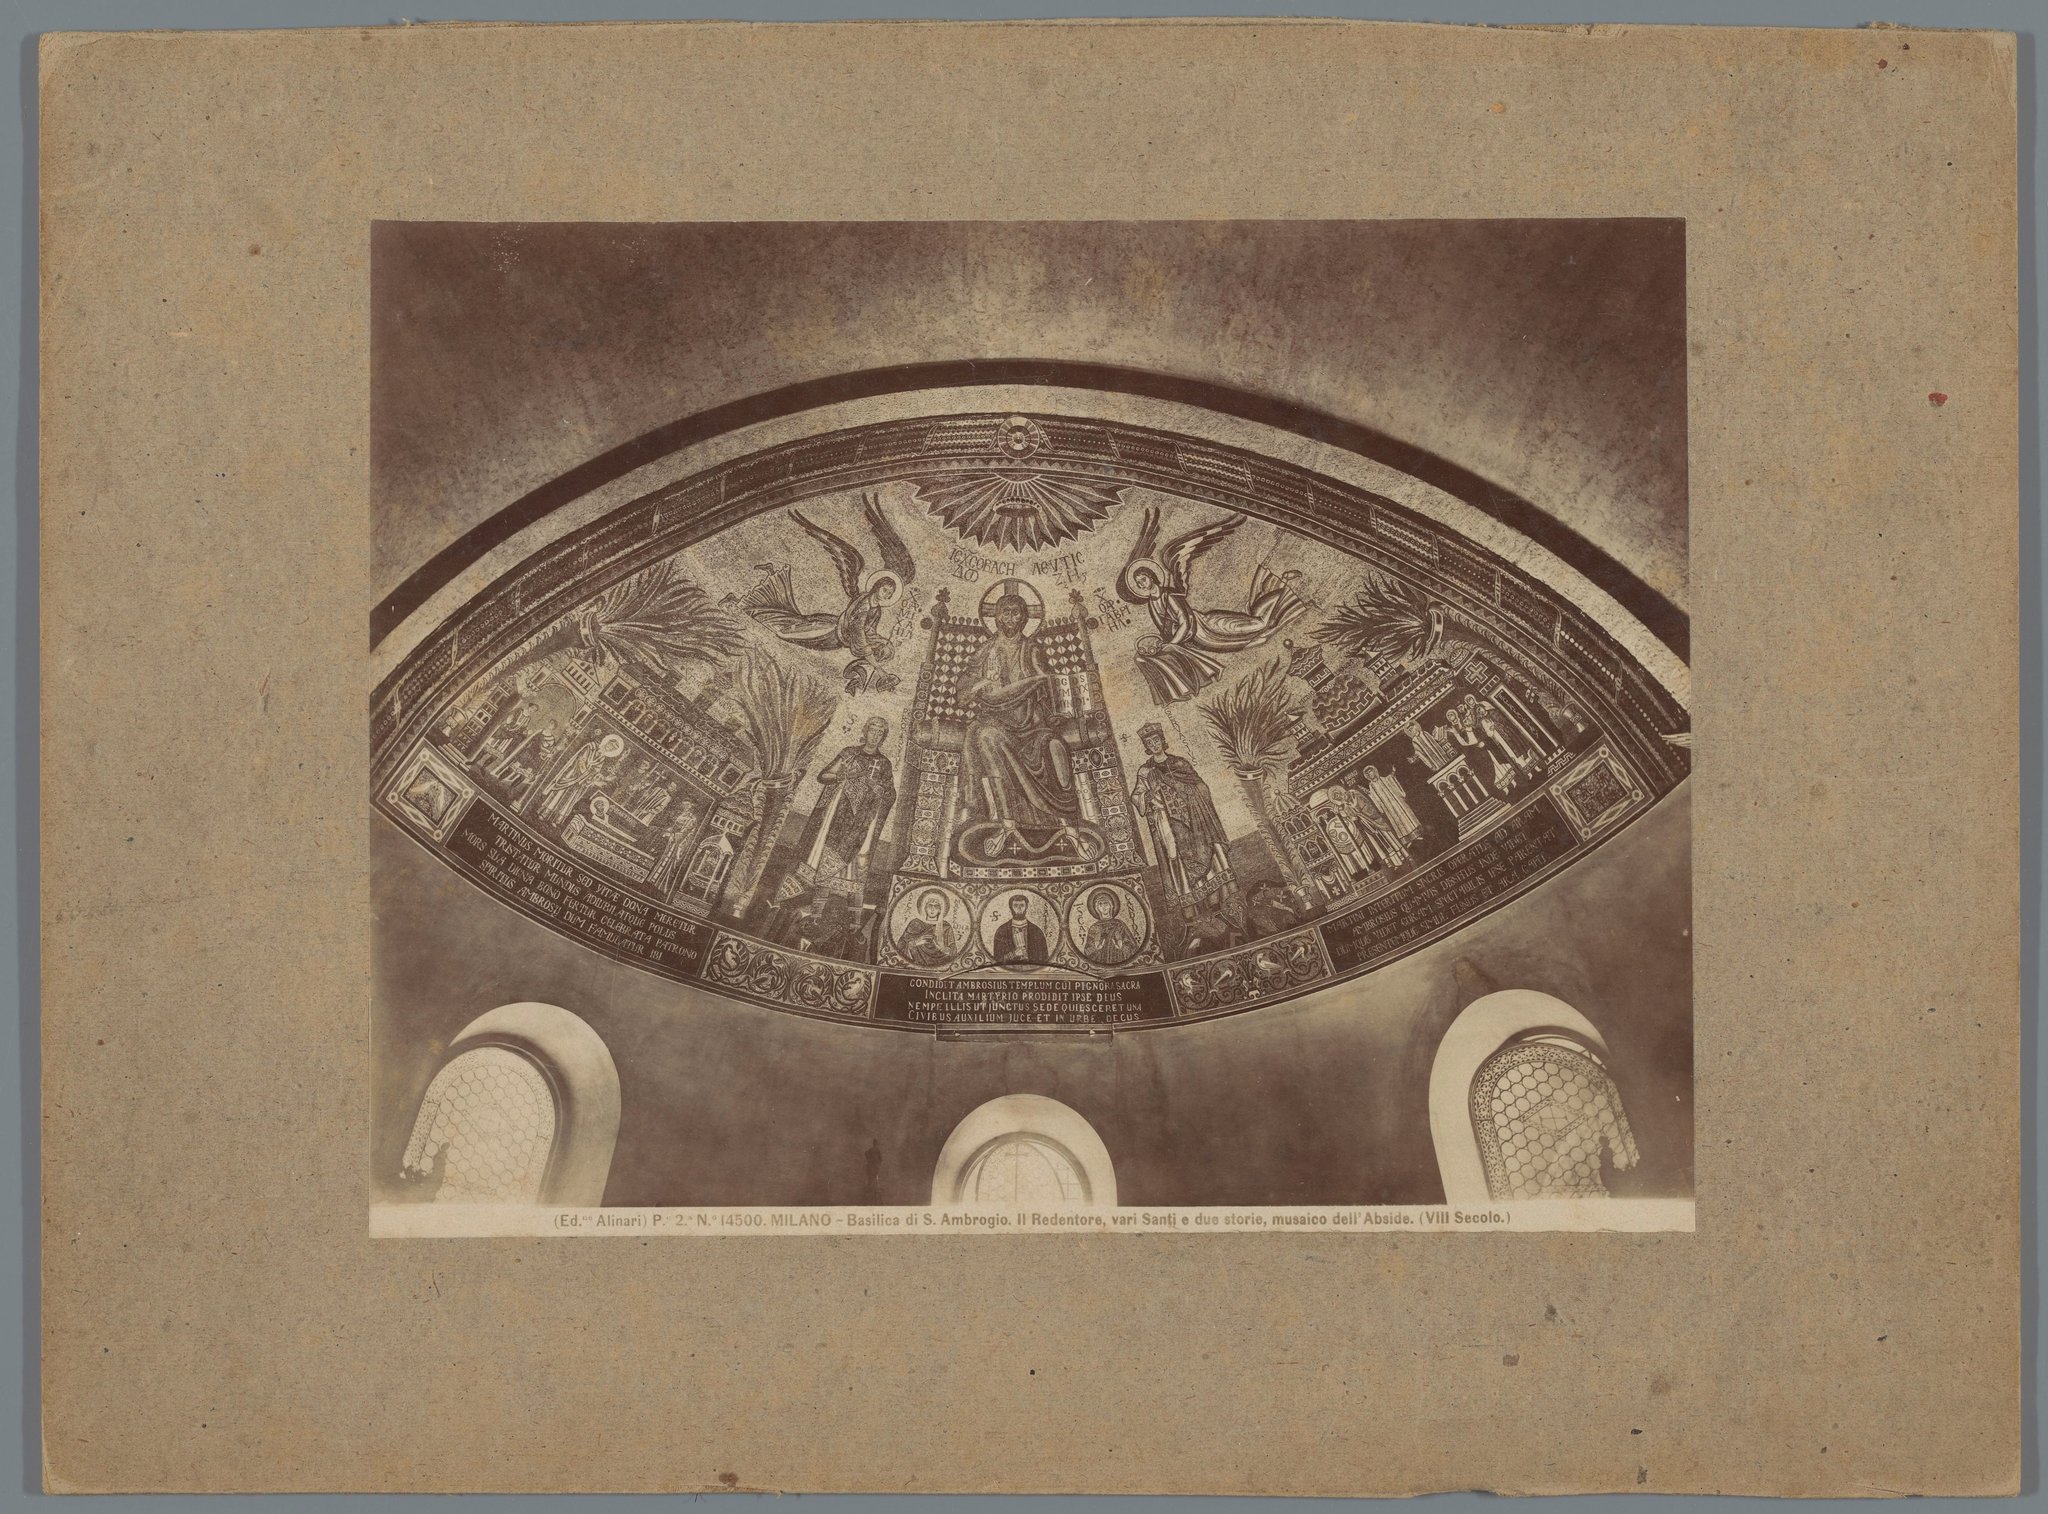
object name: photograph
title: Mozaïek in de Basiliek van Sint-Ambrosius, voorstellende Christus met heiligen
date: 1875-1900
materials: cardboard, photographic support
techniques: albumen print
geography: basiliek van sint-ambrosius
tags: art (+ mosaic making), saints, christ, parts of church interior: choir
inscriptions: number: ‘P.e 2.a N.o 14500.’, collector's mark: Lugt 3937